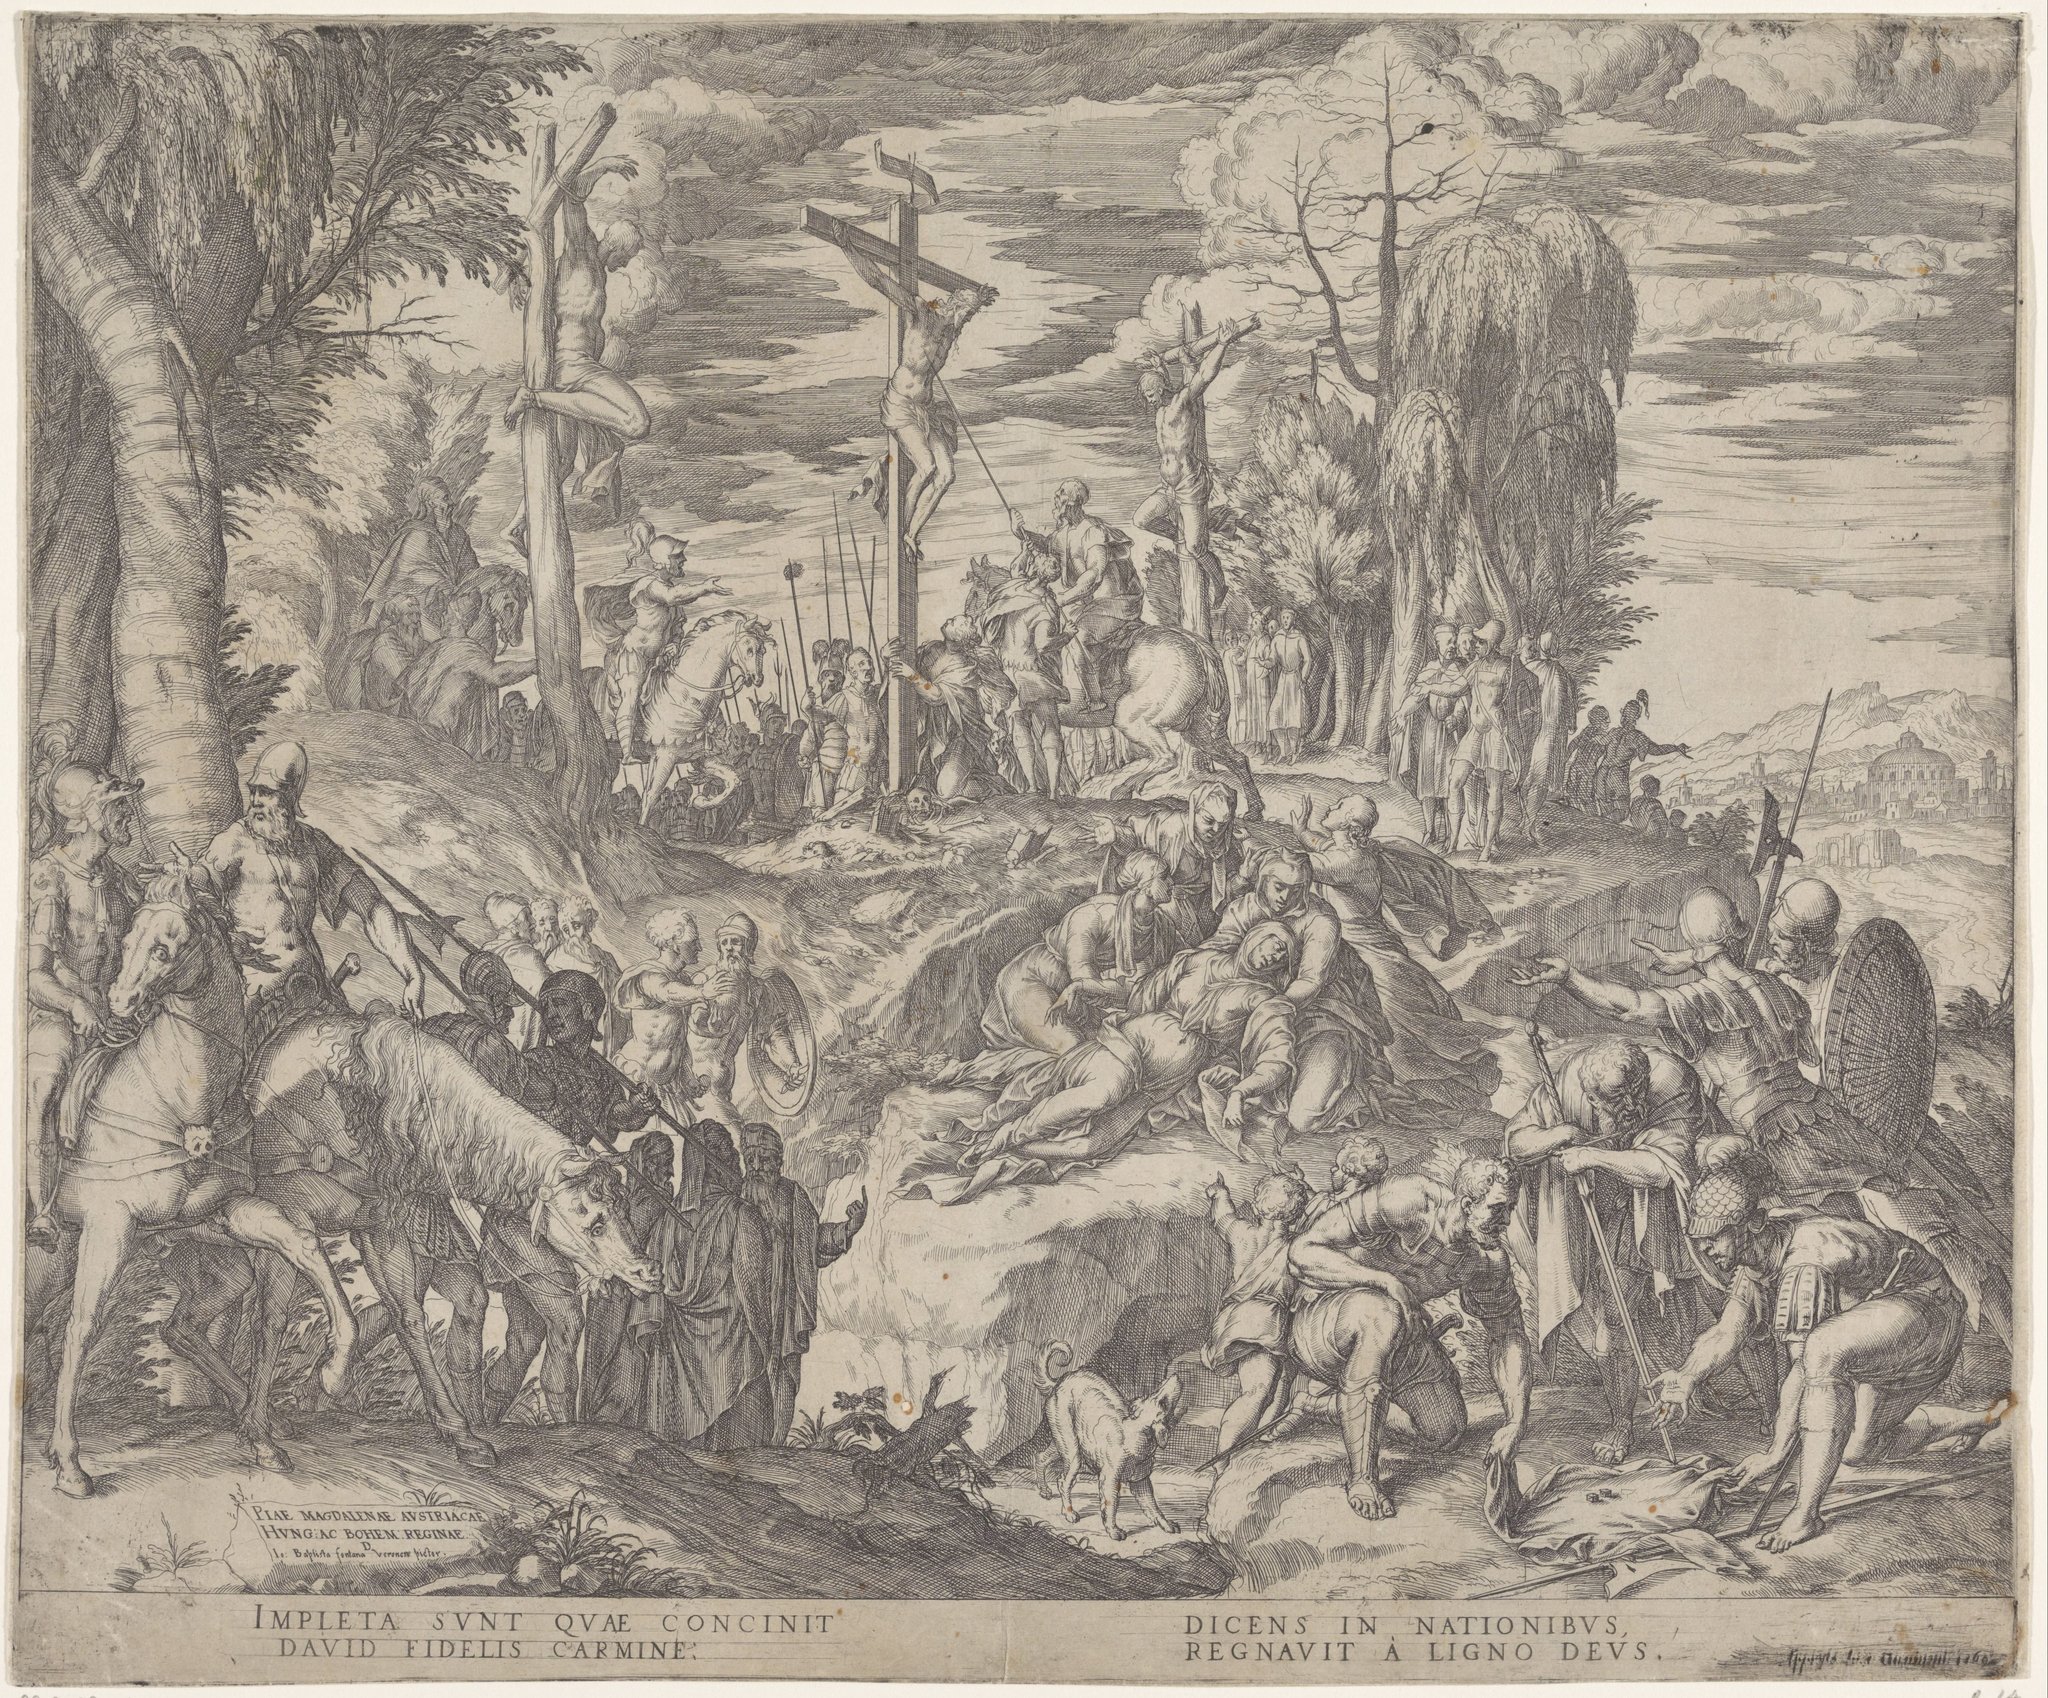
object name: print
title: Calvarieberg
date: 1569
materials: paper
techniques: etching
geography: italy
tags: crucified christ with other persons, soldiers throwing dice for christ's seamless garment ~ christ's death on the cross, crucified christ with stephaton and/or longinus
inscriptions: collector's mark: Lugt 2228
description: Gezicht op de Calvarieberg (Golgota) met de drie kruisen. Christus hangt aan het middelste kruis, tussen de twee misdadigers. Voor Christus staat Longinus die hem steekt met zijn lans. Rond de kruisen staan soldaten. Centraal zitten de treurende Maria's en Johannes de Evangelist. Op de voorgrond rechts soldaten die dobbelen om de mantel van Christus. Tekst in ondermarge.